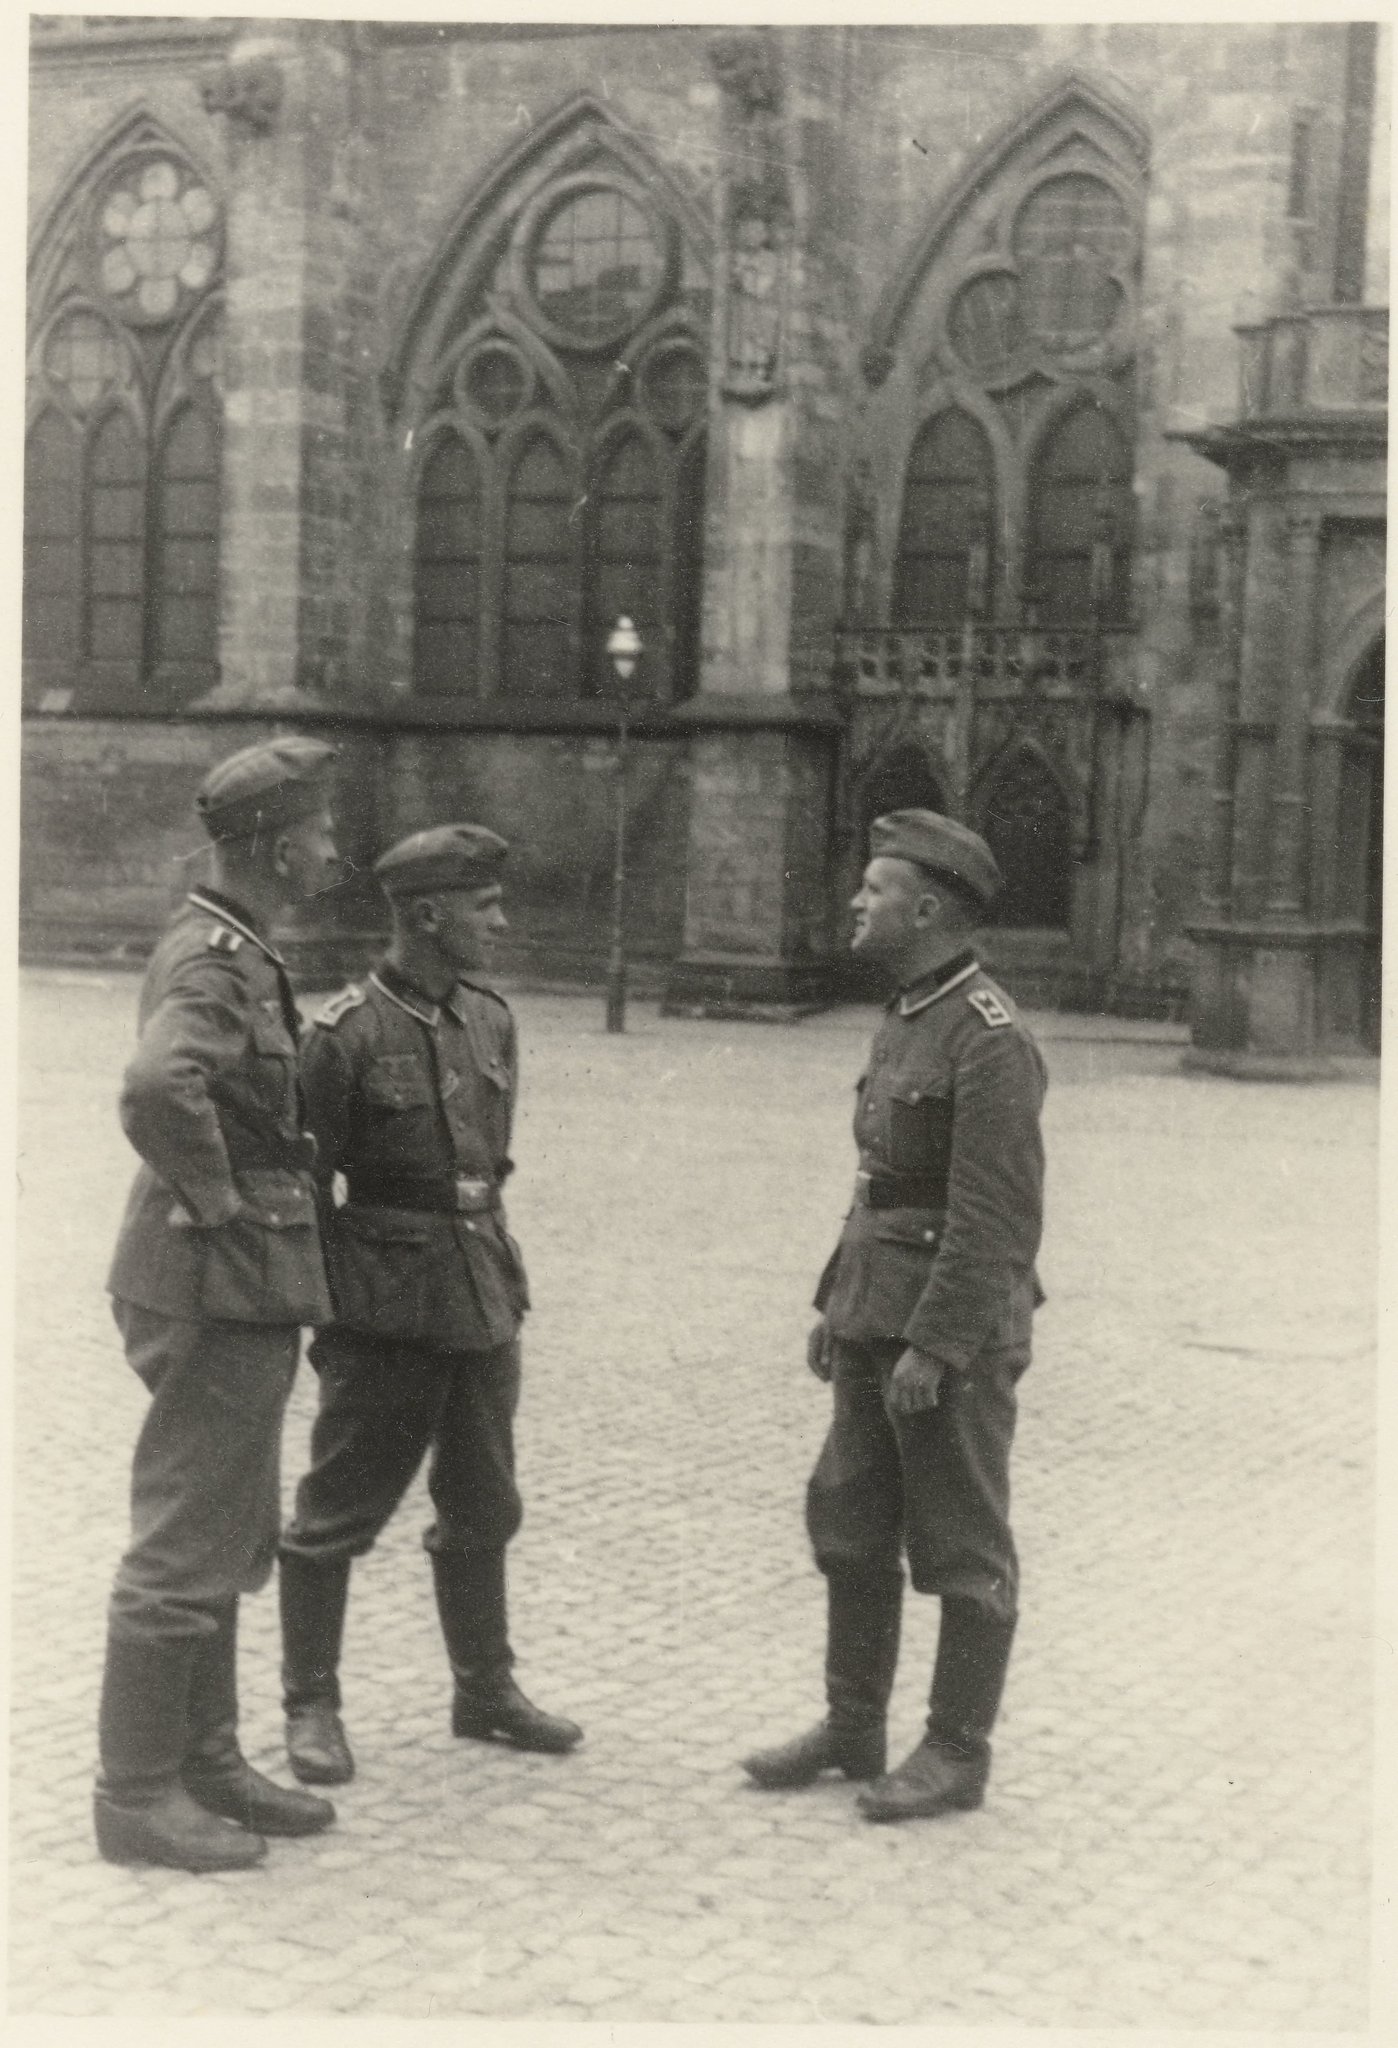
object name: photograph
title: Drie Duitse soldaten voor een kerk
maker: Anonymous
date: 1940-1945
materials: photographic support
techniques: gelatin silver print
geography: germany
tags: netherlands, germany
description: Drie Duitse soldaten staande voor een kerk. Foto behorend bij album 'Kriegserinnerungen'.